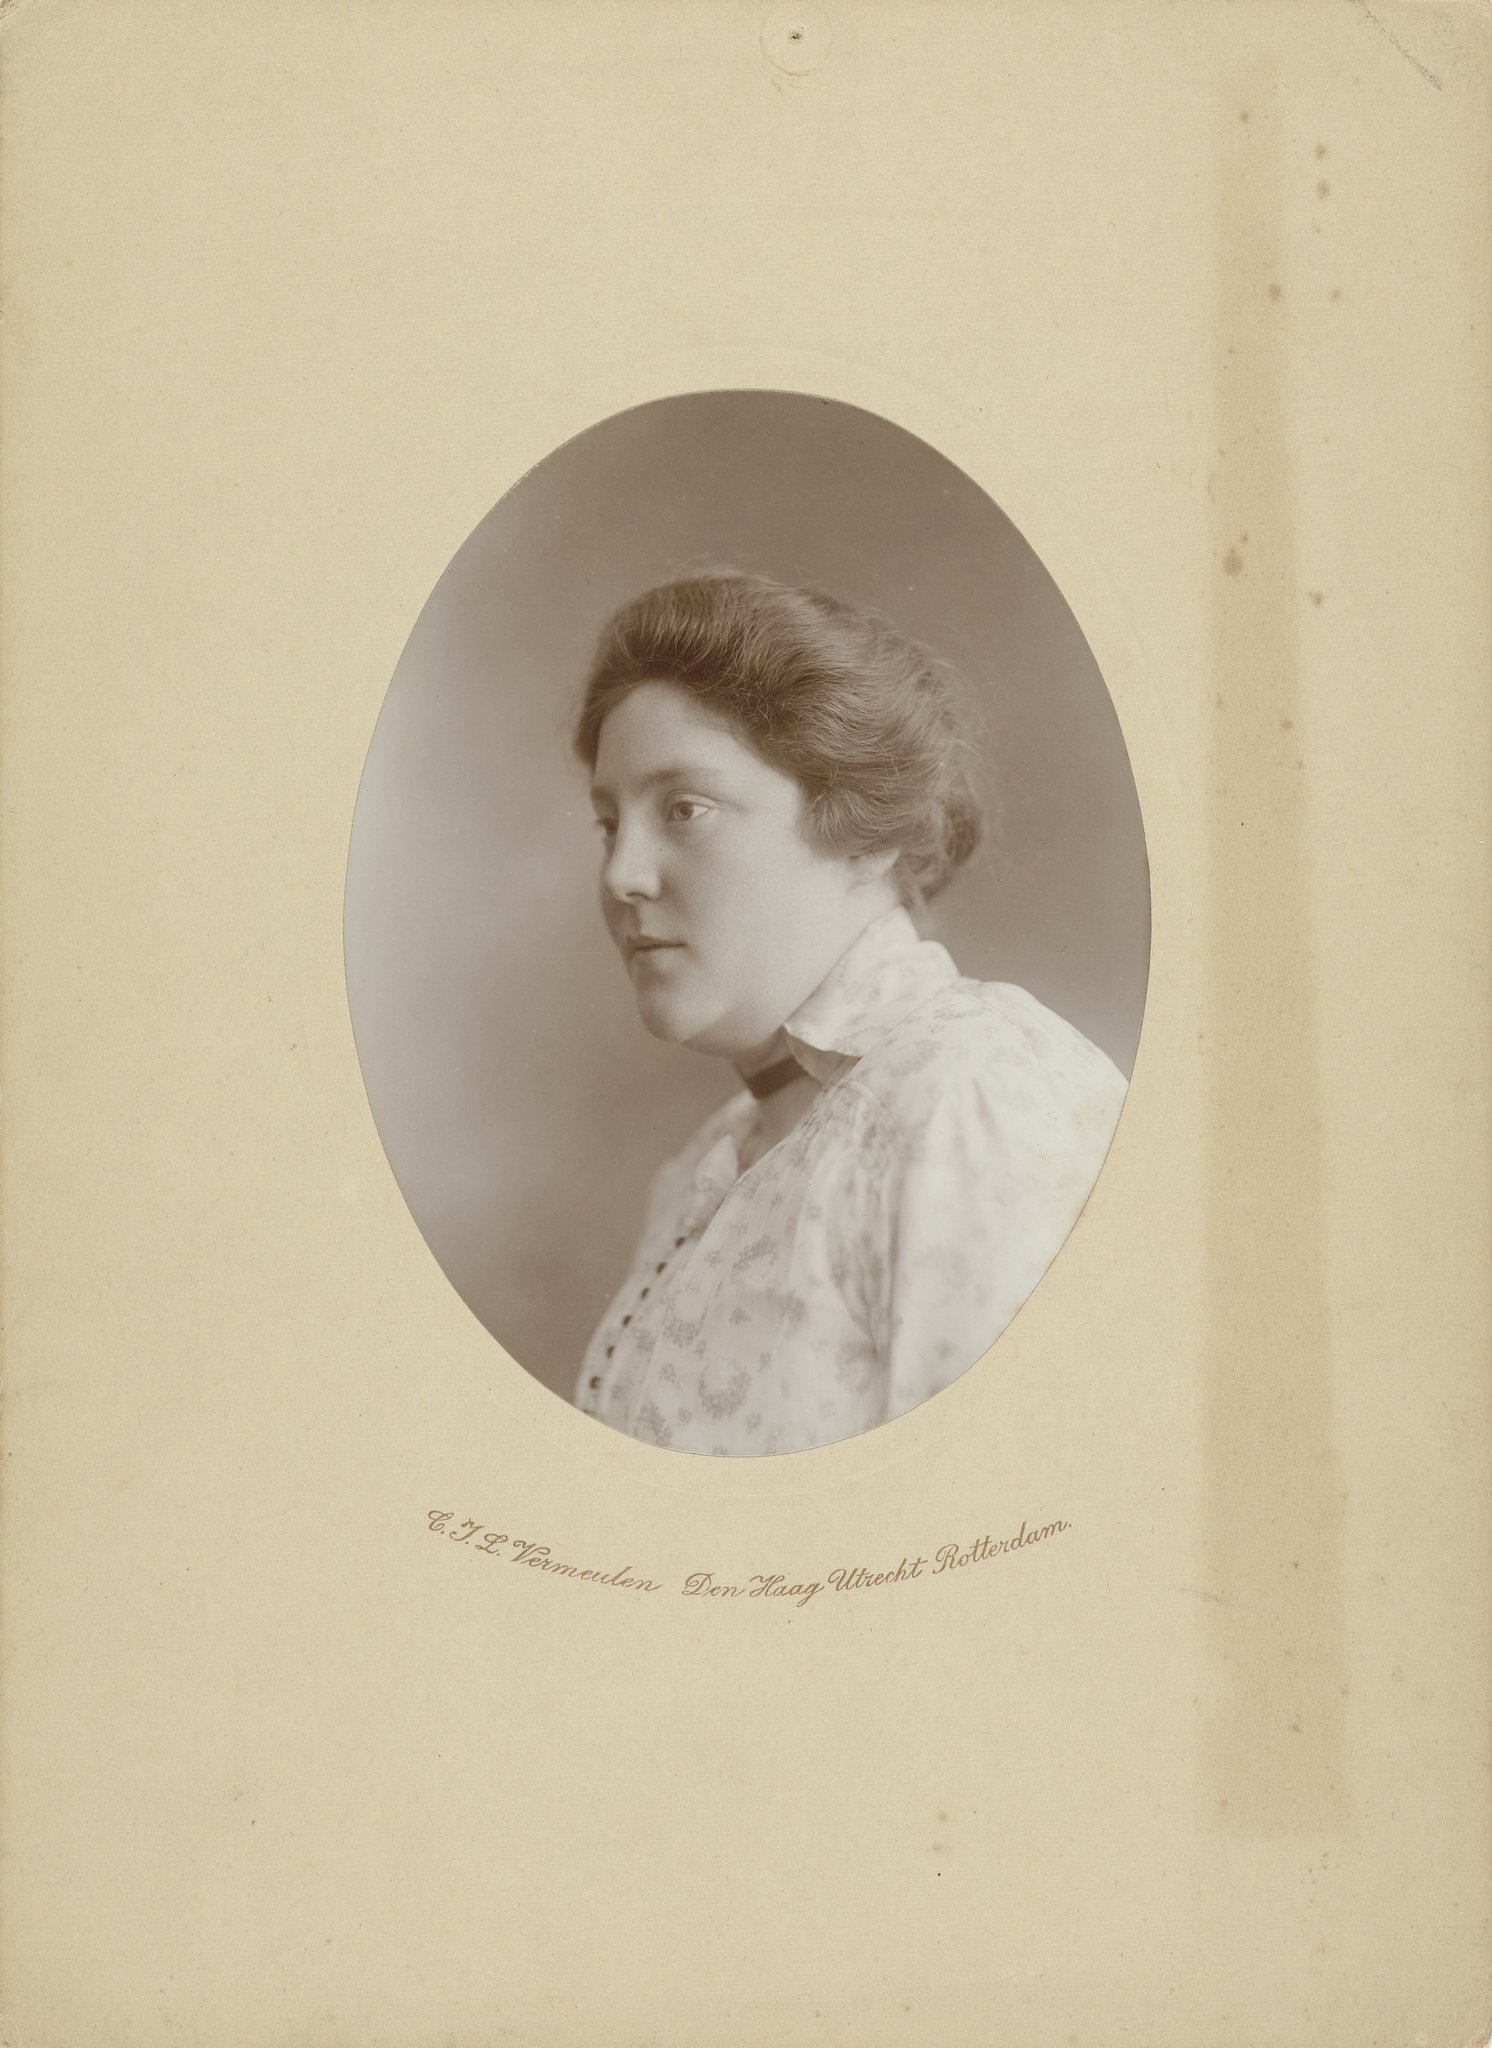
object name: photograph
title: Ovaal portret van Tine Vermeulen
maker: cornelis johannes lodewicus vermeulen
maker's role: fotograaf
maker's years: 1861-1936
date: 1910-1930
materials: cardboard, photographic support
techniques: collodion silver print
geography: the hague